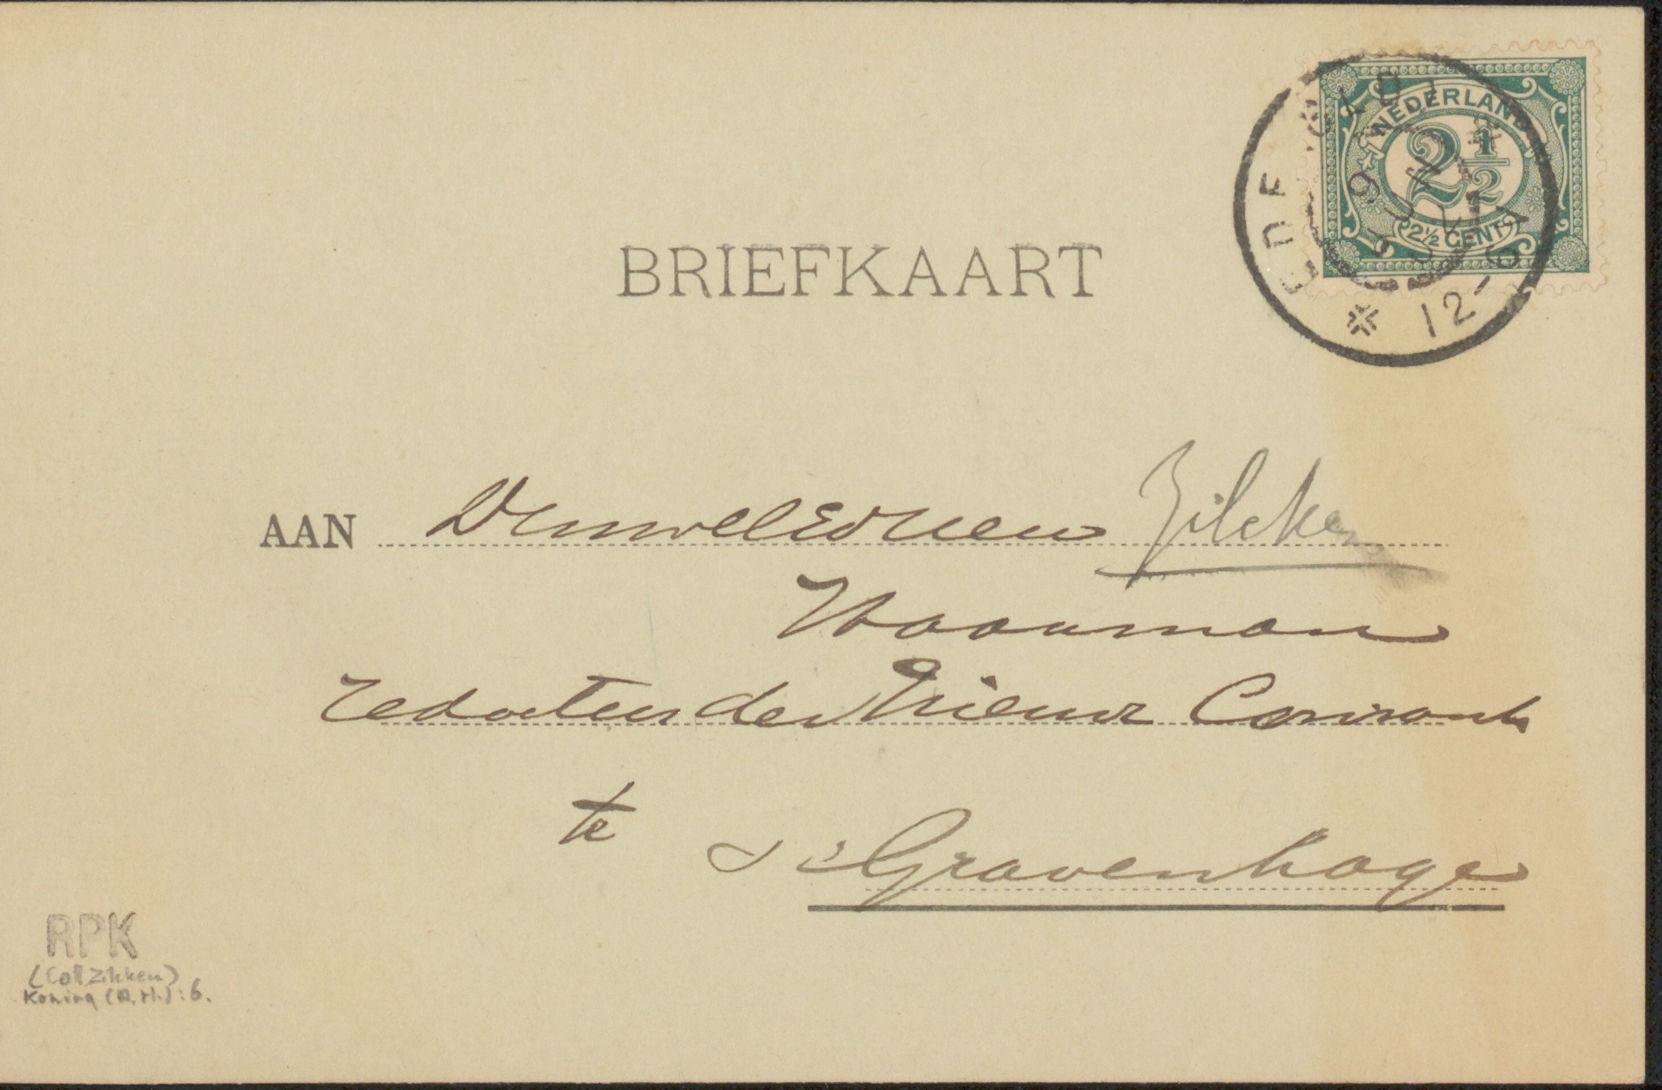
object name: postcard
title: Briefkaart aan Pieter Anne Haaxman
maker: arnold koning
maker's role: print maker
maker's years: 1860-1945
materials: cardboard, ink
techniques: pen, writing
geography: ede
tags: amsterdam, draughtsman, hermanus gijsbertus tersteeg, rotterdam, herman robbers, delft, pieter anne haaxman, painter, philip zilcken, drawing, painting (including book-illumination, miniature-painting)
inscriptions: collector's mark: ‘RPK’